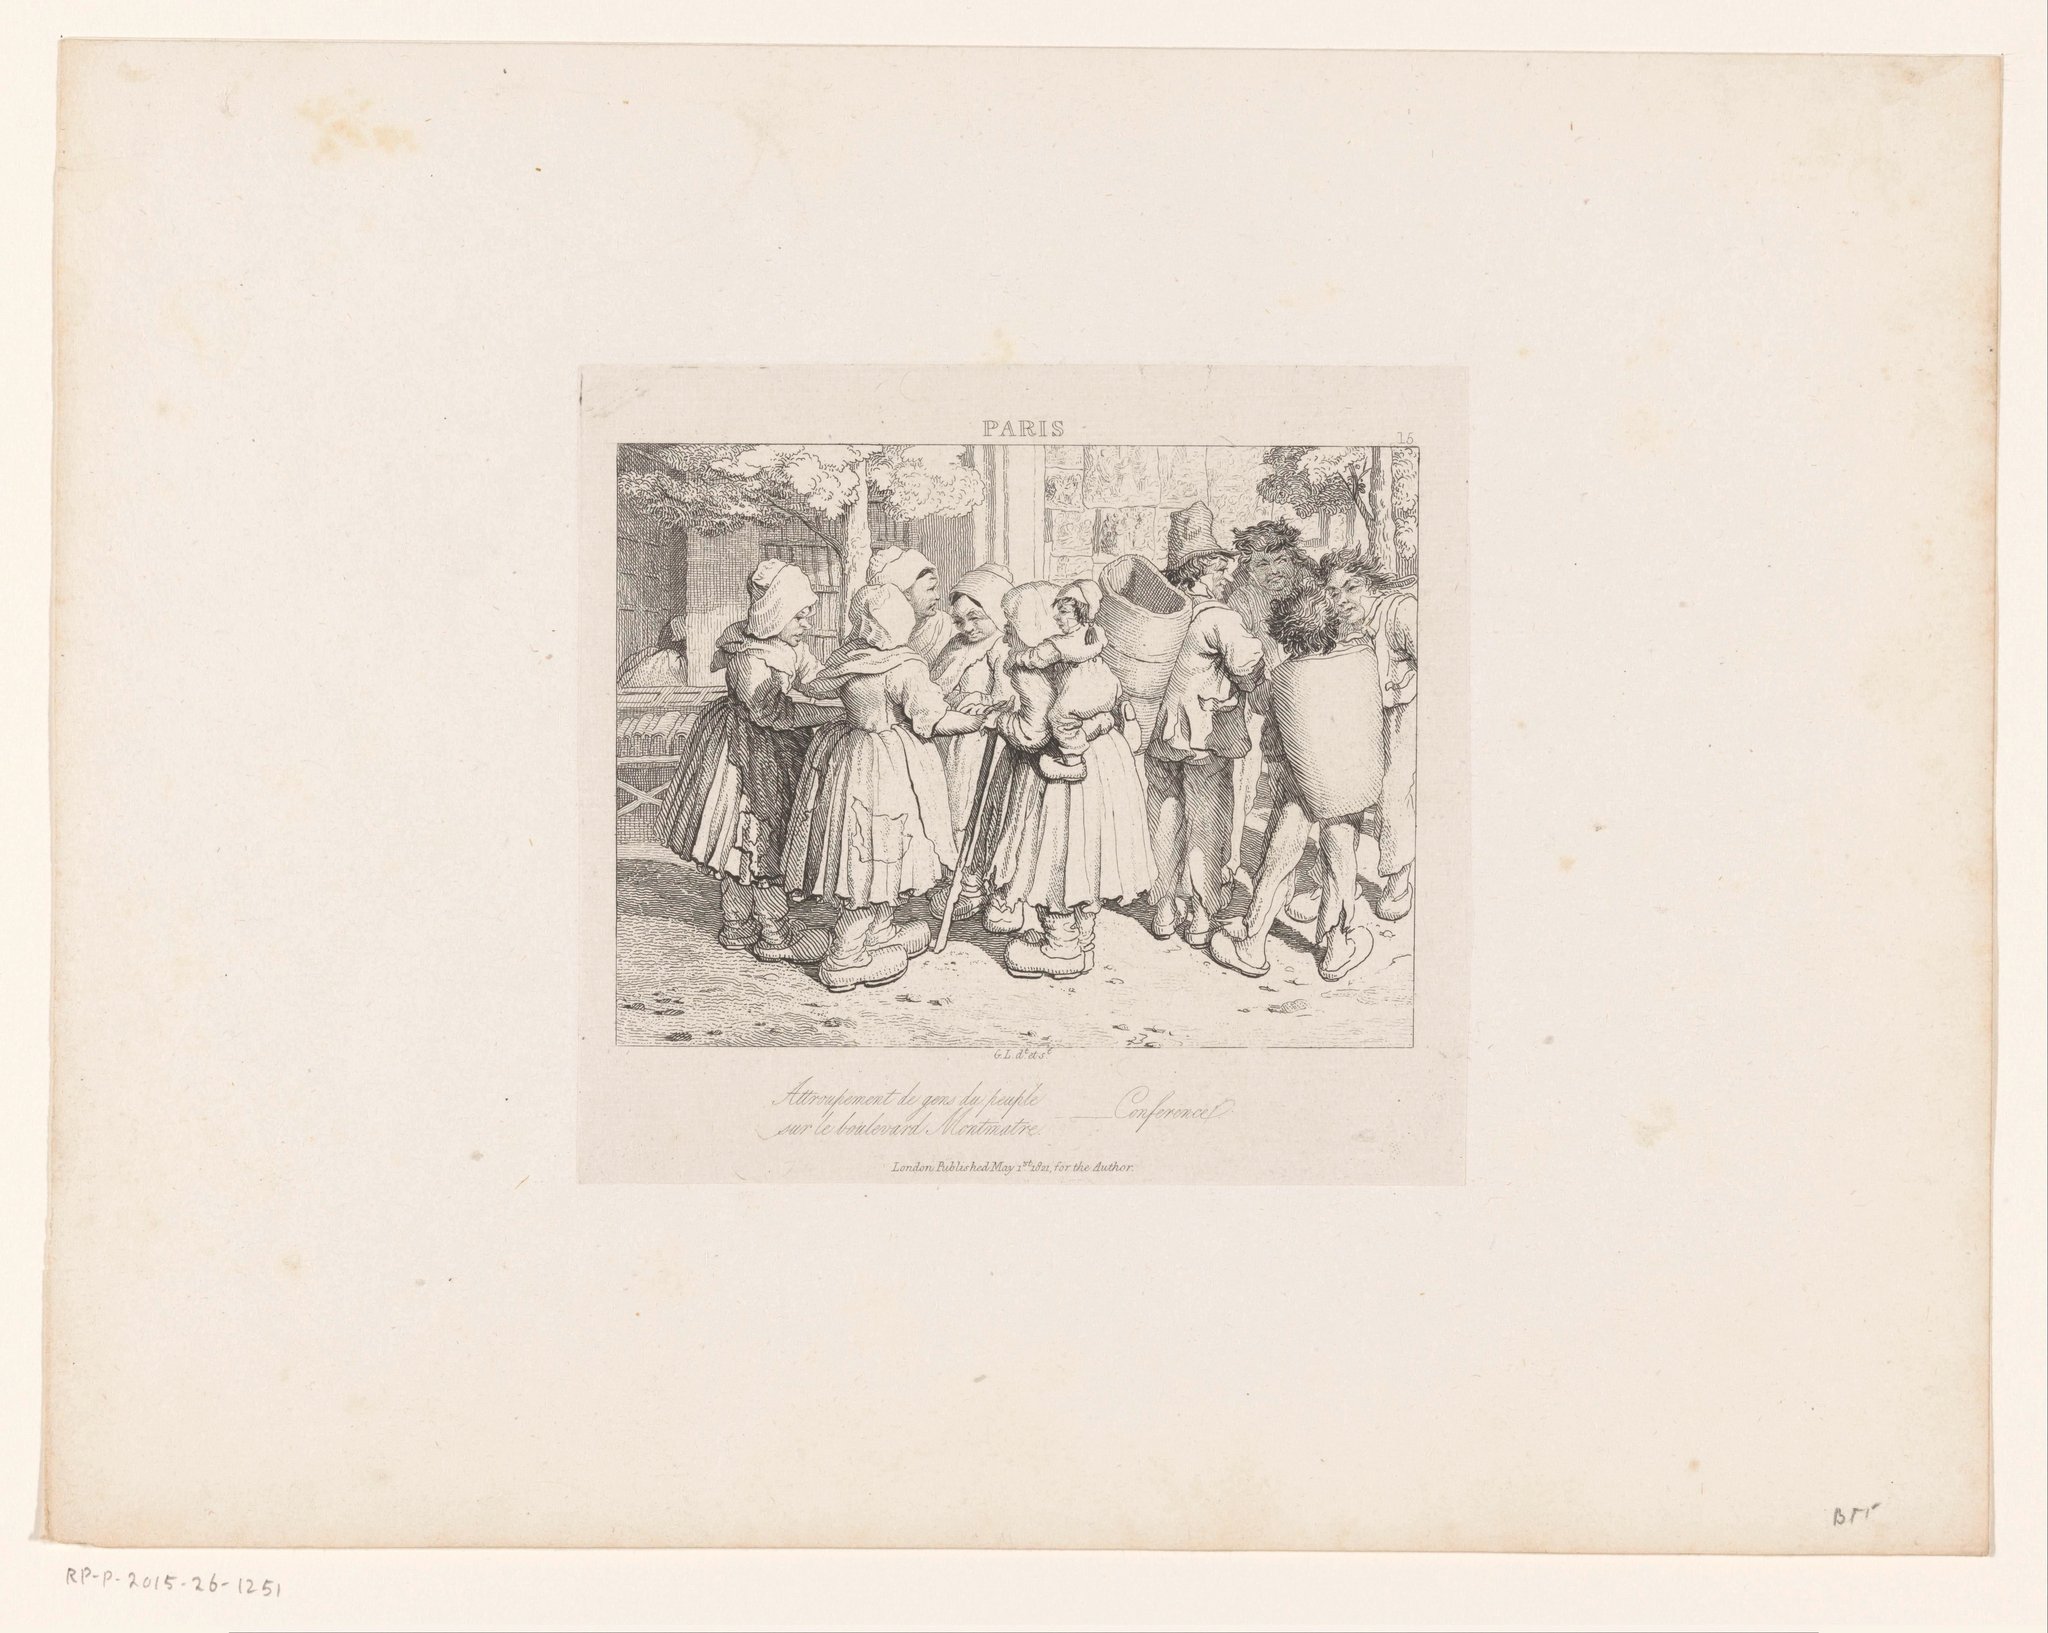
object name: print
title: Paris / Attroupement de gens du peuple sur le boulevard Montmartre / Conference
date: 1805-1821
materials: paper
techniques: etching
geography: london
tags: art dealer (+ graphic arts), porter, bearer, book-shop, bookseller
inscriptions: collector's mark: Lugt 4780, collector's mark: Lugt 2228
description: Straatgezicht met vier mannen en vijf vrouwen. De mannen dragen manen op hun rug. In de achtergrond een boek- en prenthandel. Rechtsboven genummerd: 15.